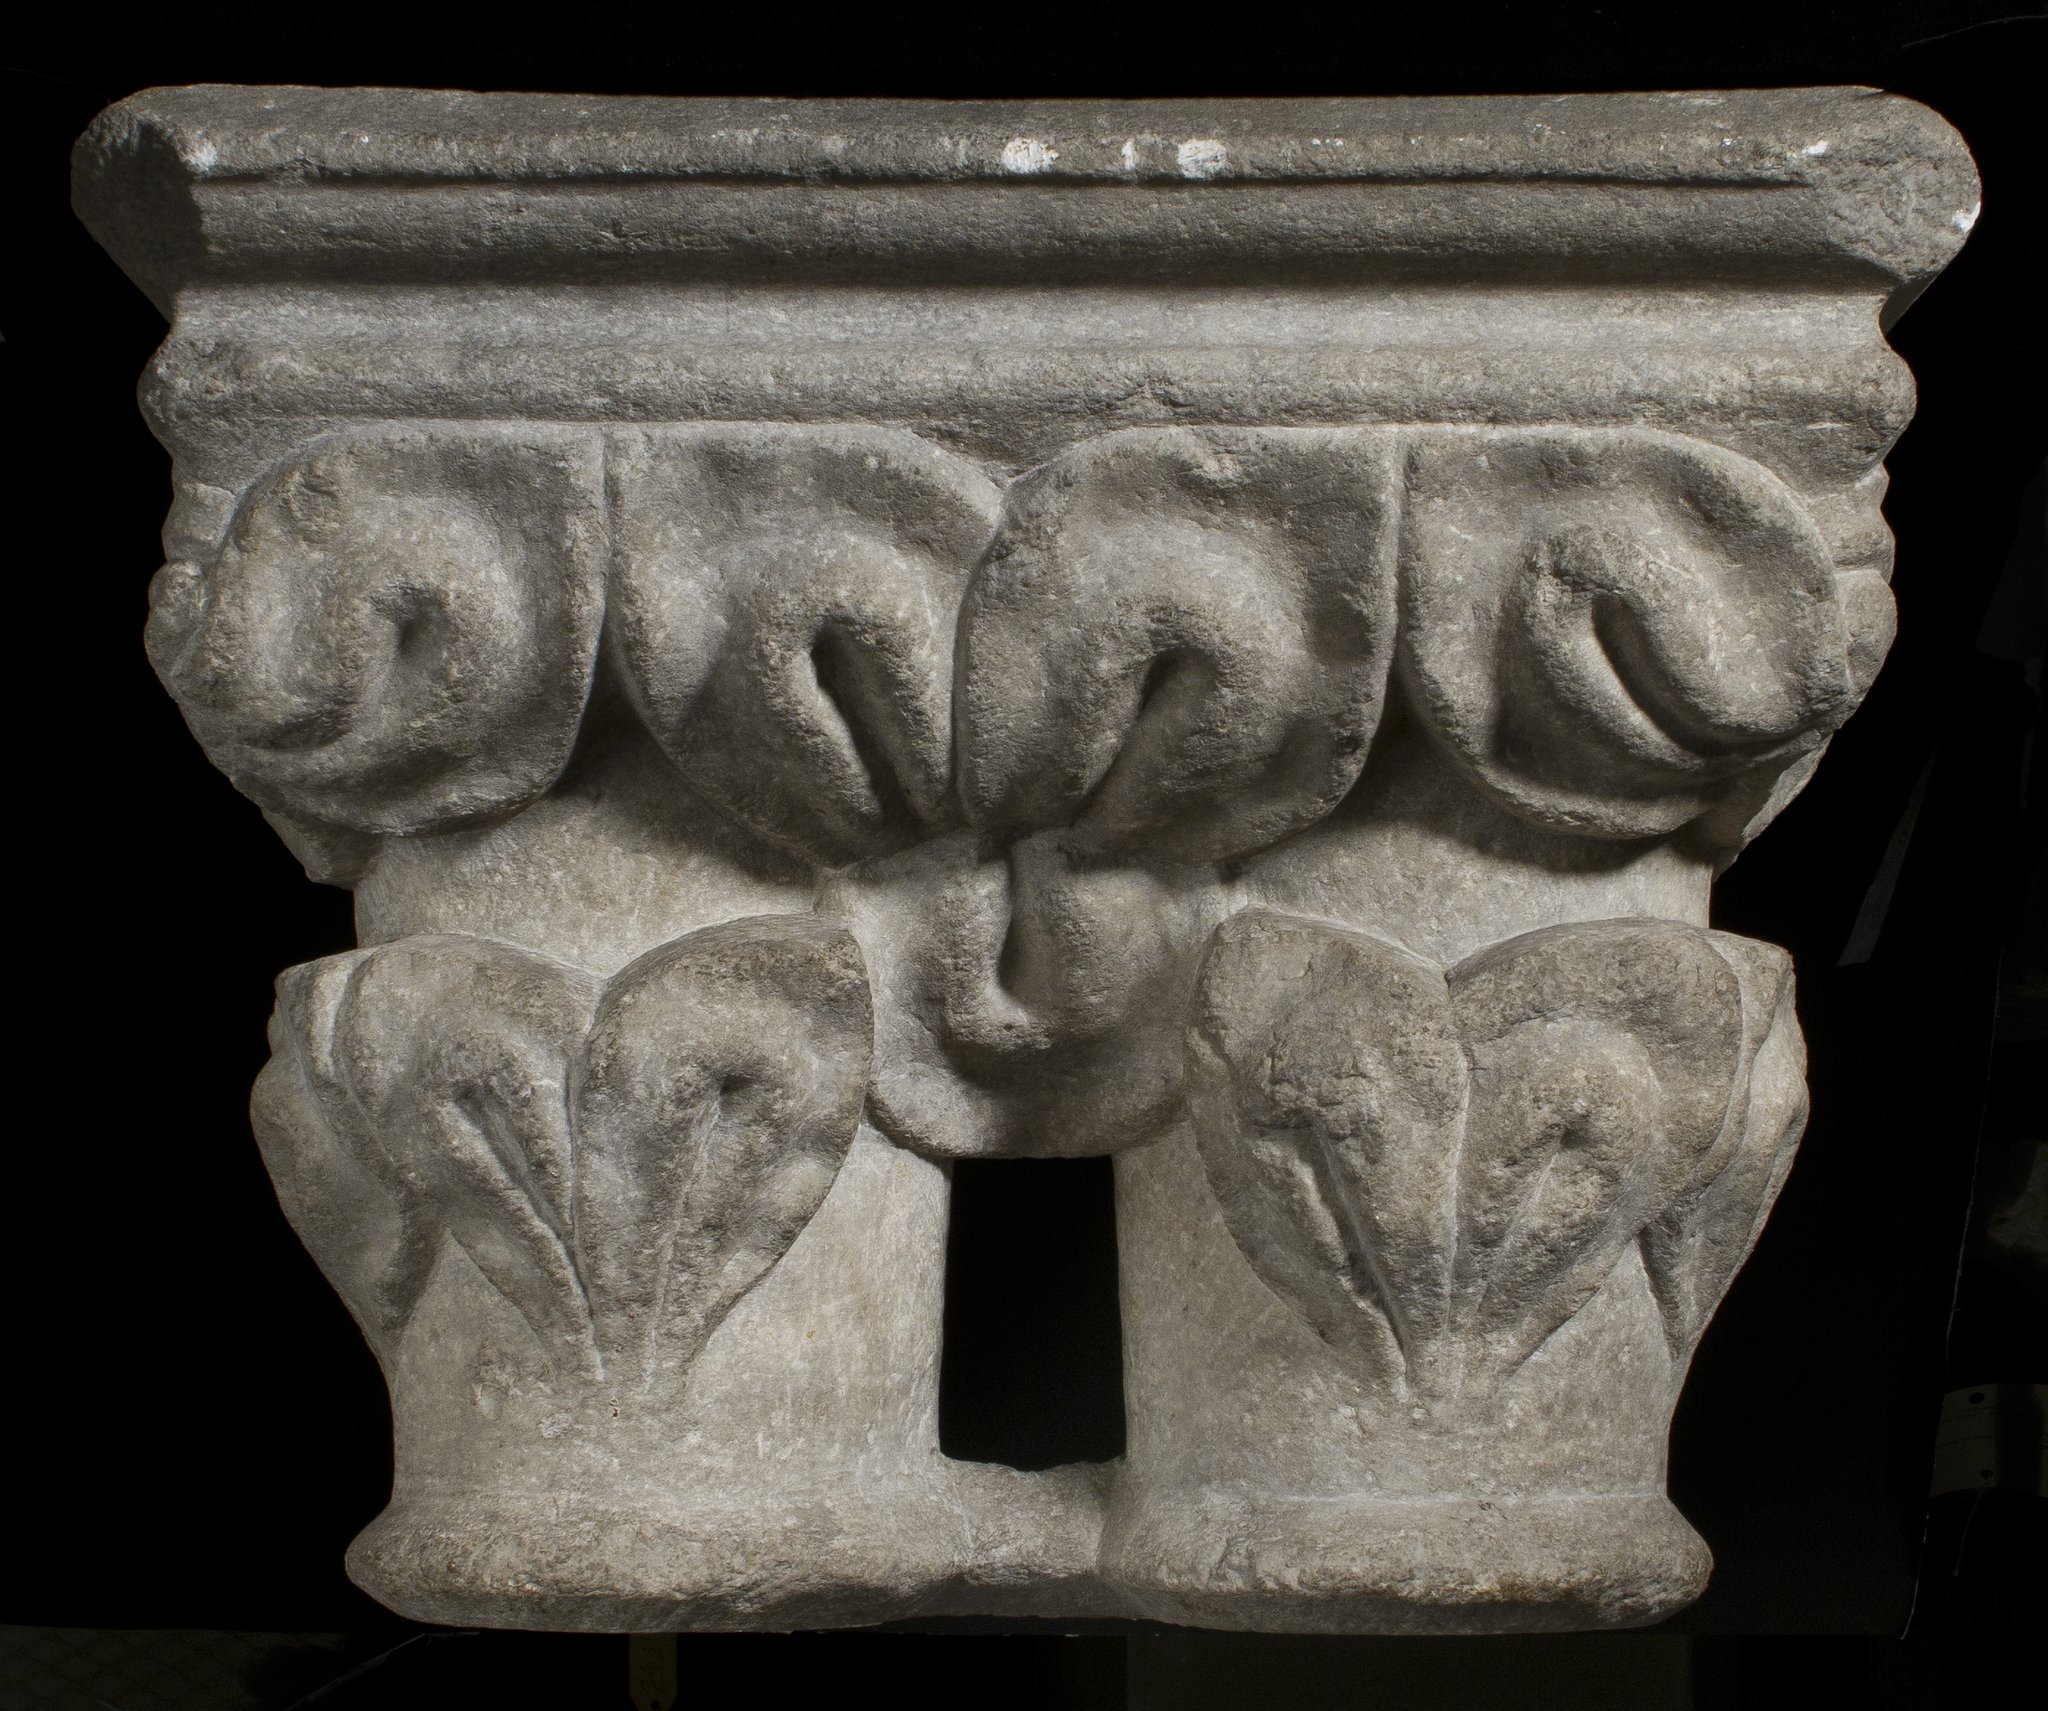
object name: capital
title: Double Capital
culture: french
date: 1267-1333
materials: marble